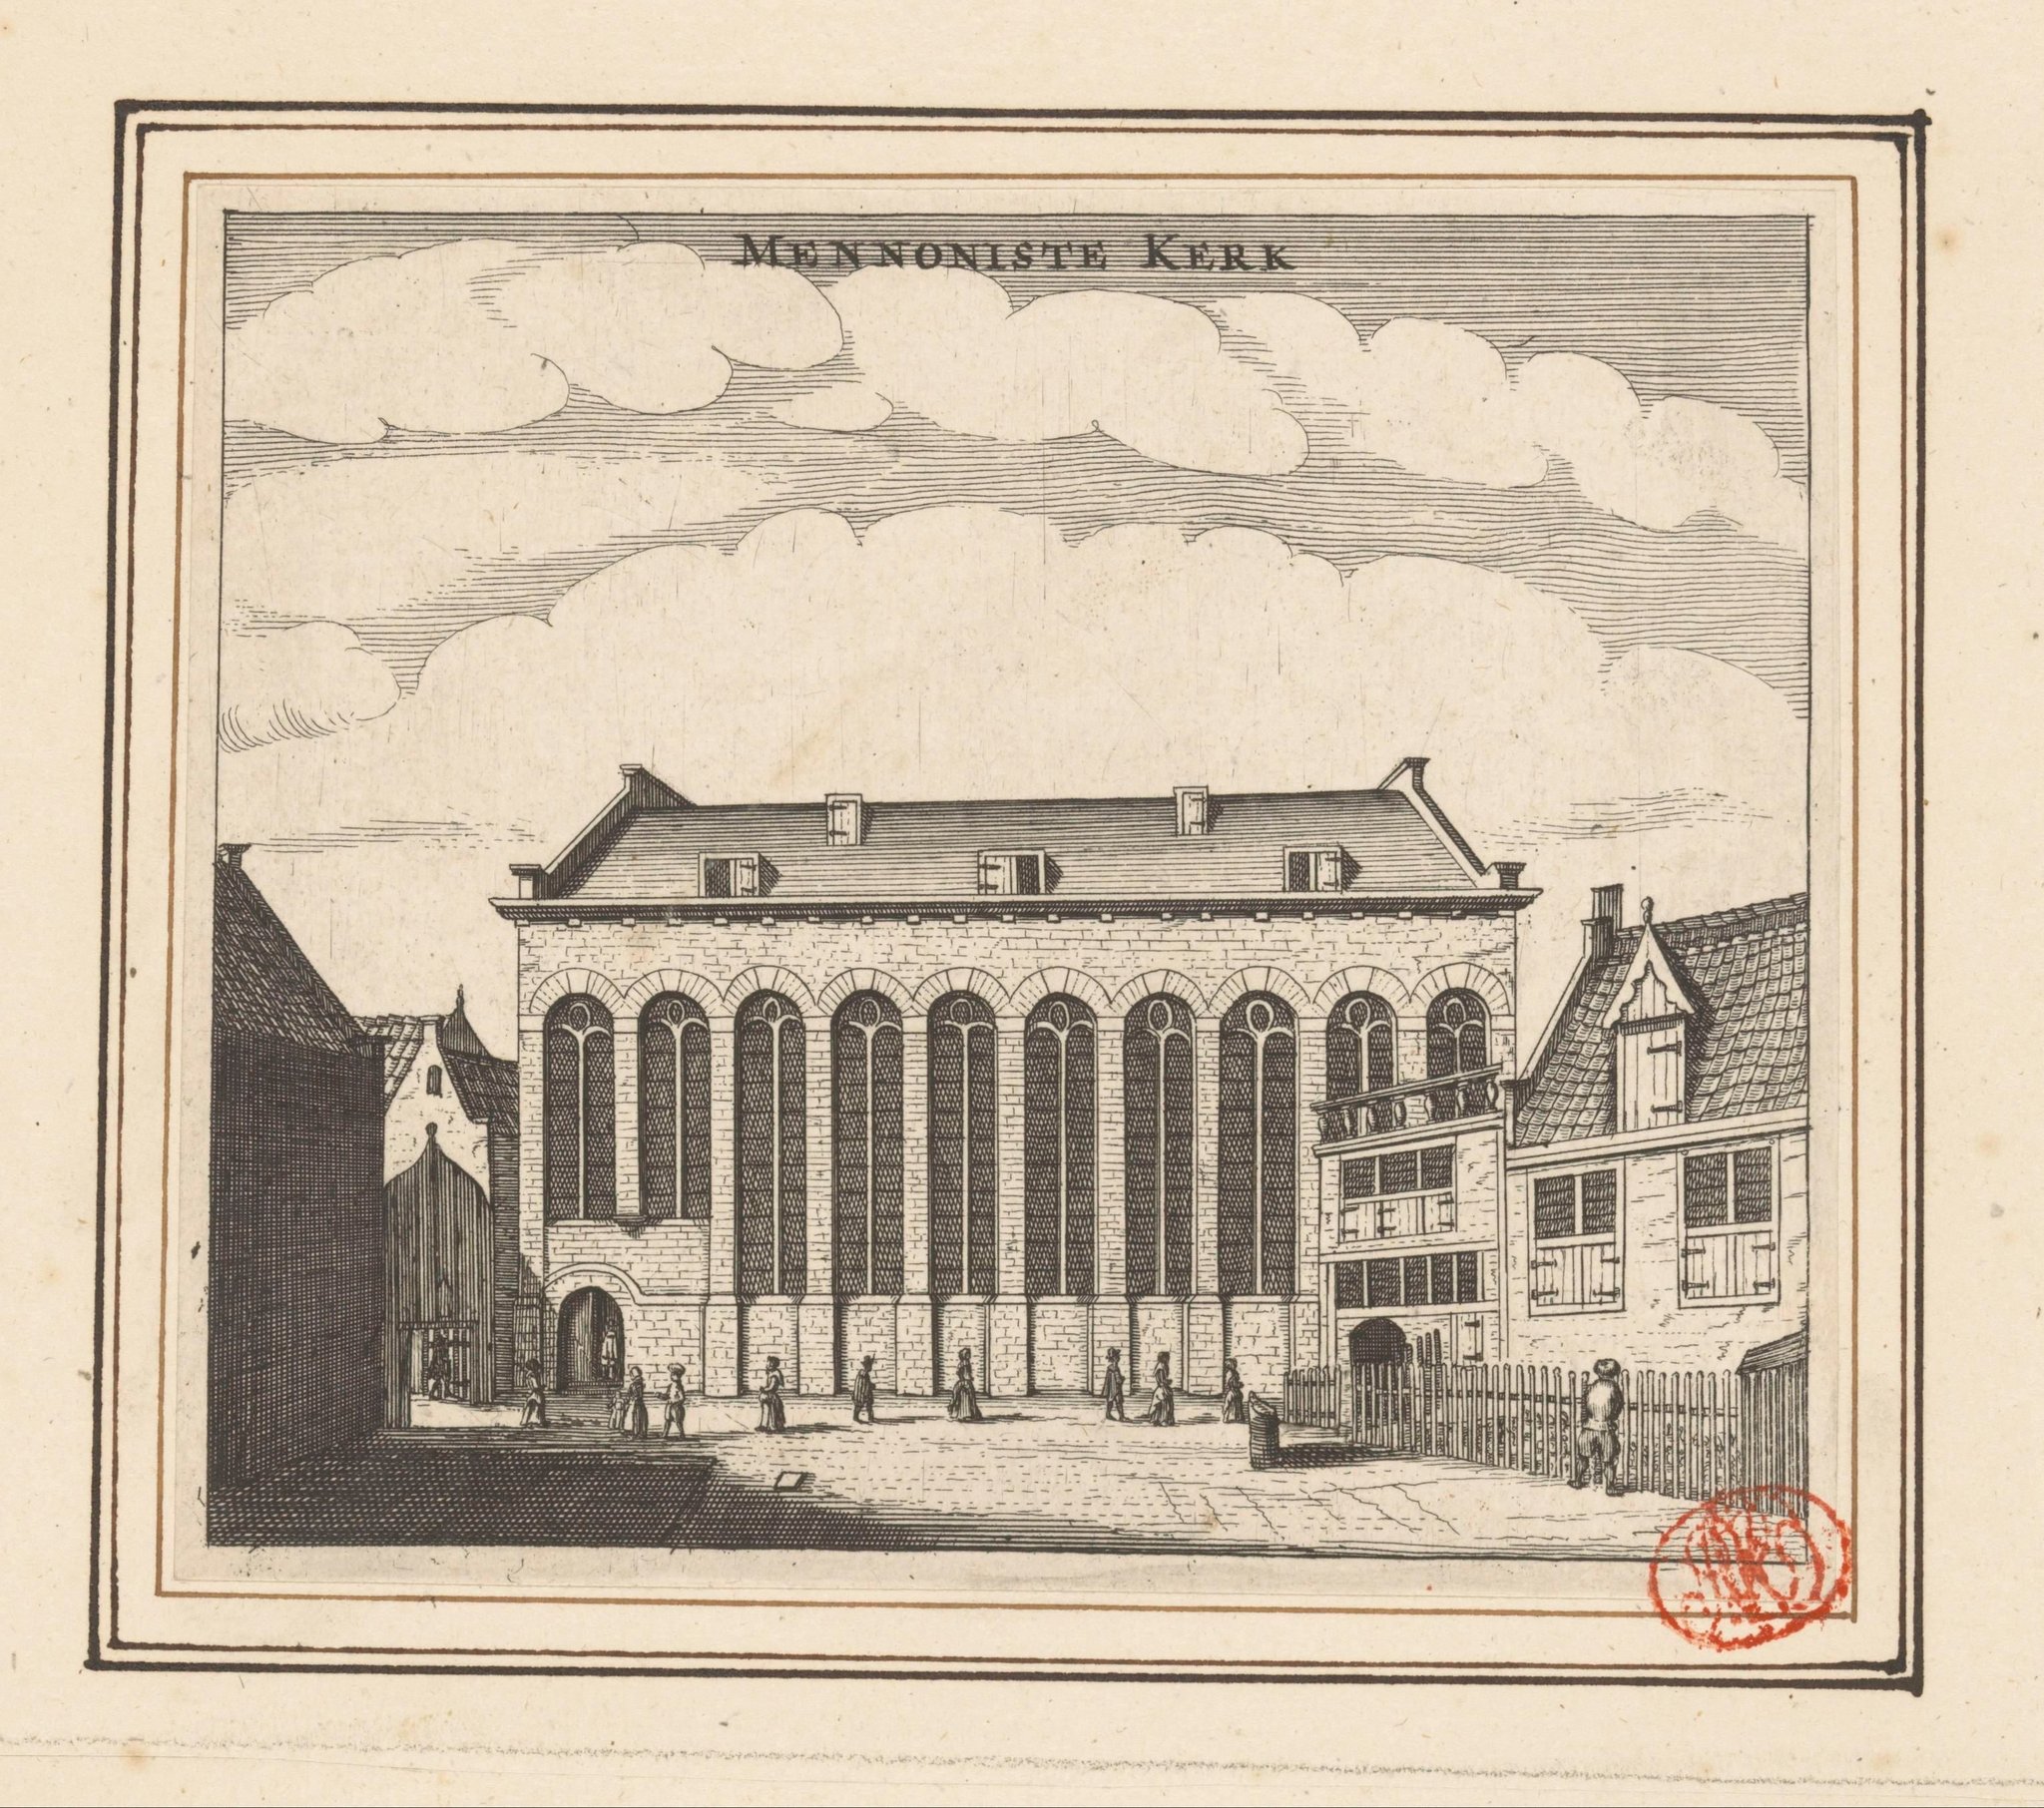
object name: print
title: Gezicht op de Doopsgezinde Kerk Bij 't Lam te Amsterdam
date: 1664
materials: paper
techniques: engraving, etching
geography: amsterdam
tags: protestant churches and denominations (mennonites), church (exterior)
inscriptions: collector's mark: Lugt 2233, collector's mark: Lugt 195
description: Huidige staat (en mogelijk ook tweede staat) van prent ook gebruikt in: Fockens, Melchior. Beschrijving Der wijdt-vermaarde Koop-stadt Amstelredam, Van haar eerste beginselen, zedert den Jare 1203. oude Voorrechten, verscheyde Vergrootingenoude Voor-rechten, en verscheyde Vergrootingen (…). 3e druk. Amsterdam: Marcus Willemsz. Doornick, 1664. Tweede bekende staat (met toevoeging ‘genaemt de Vlamingen’) ook gebruikt in: Zesen, Philipp von. Beschrybung der Weidtberuhmde Kauf-Stadt Amstelredam / Beschreibung der Stadt Amsterdam darinnen von derselben ersten ursprunge bis auf gegenwartigen zustand (…). Amsterdam: Marcus Willemsz. Doornick, 1664. Mogelijk komt de eerste staat ook voor in sommige exemplaren van deze publicatie. Derde bekende staat (met toevoeging Franse titel) ook gebruikt in: Domselaer, Tobias en Isaac Commelin. Beschryvinge van Amsterdam : haar eerste oorspronk uyt den huyze der heeren van Aemstel en Aemstellant (…). 6 delen. Amsterdam: Marcus Willemsz van Doornick, 1665. Vierde bekende staat (rechtsboven genummerd: 22) ook gebruikt in verschillende latere zeventiende- en achttiende-eeuwse publicaties.